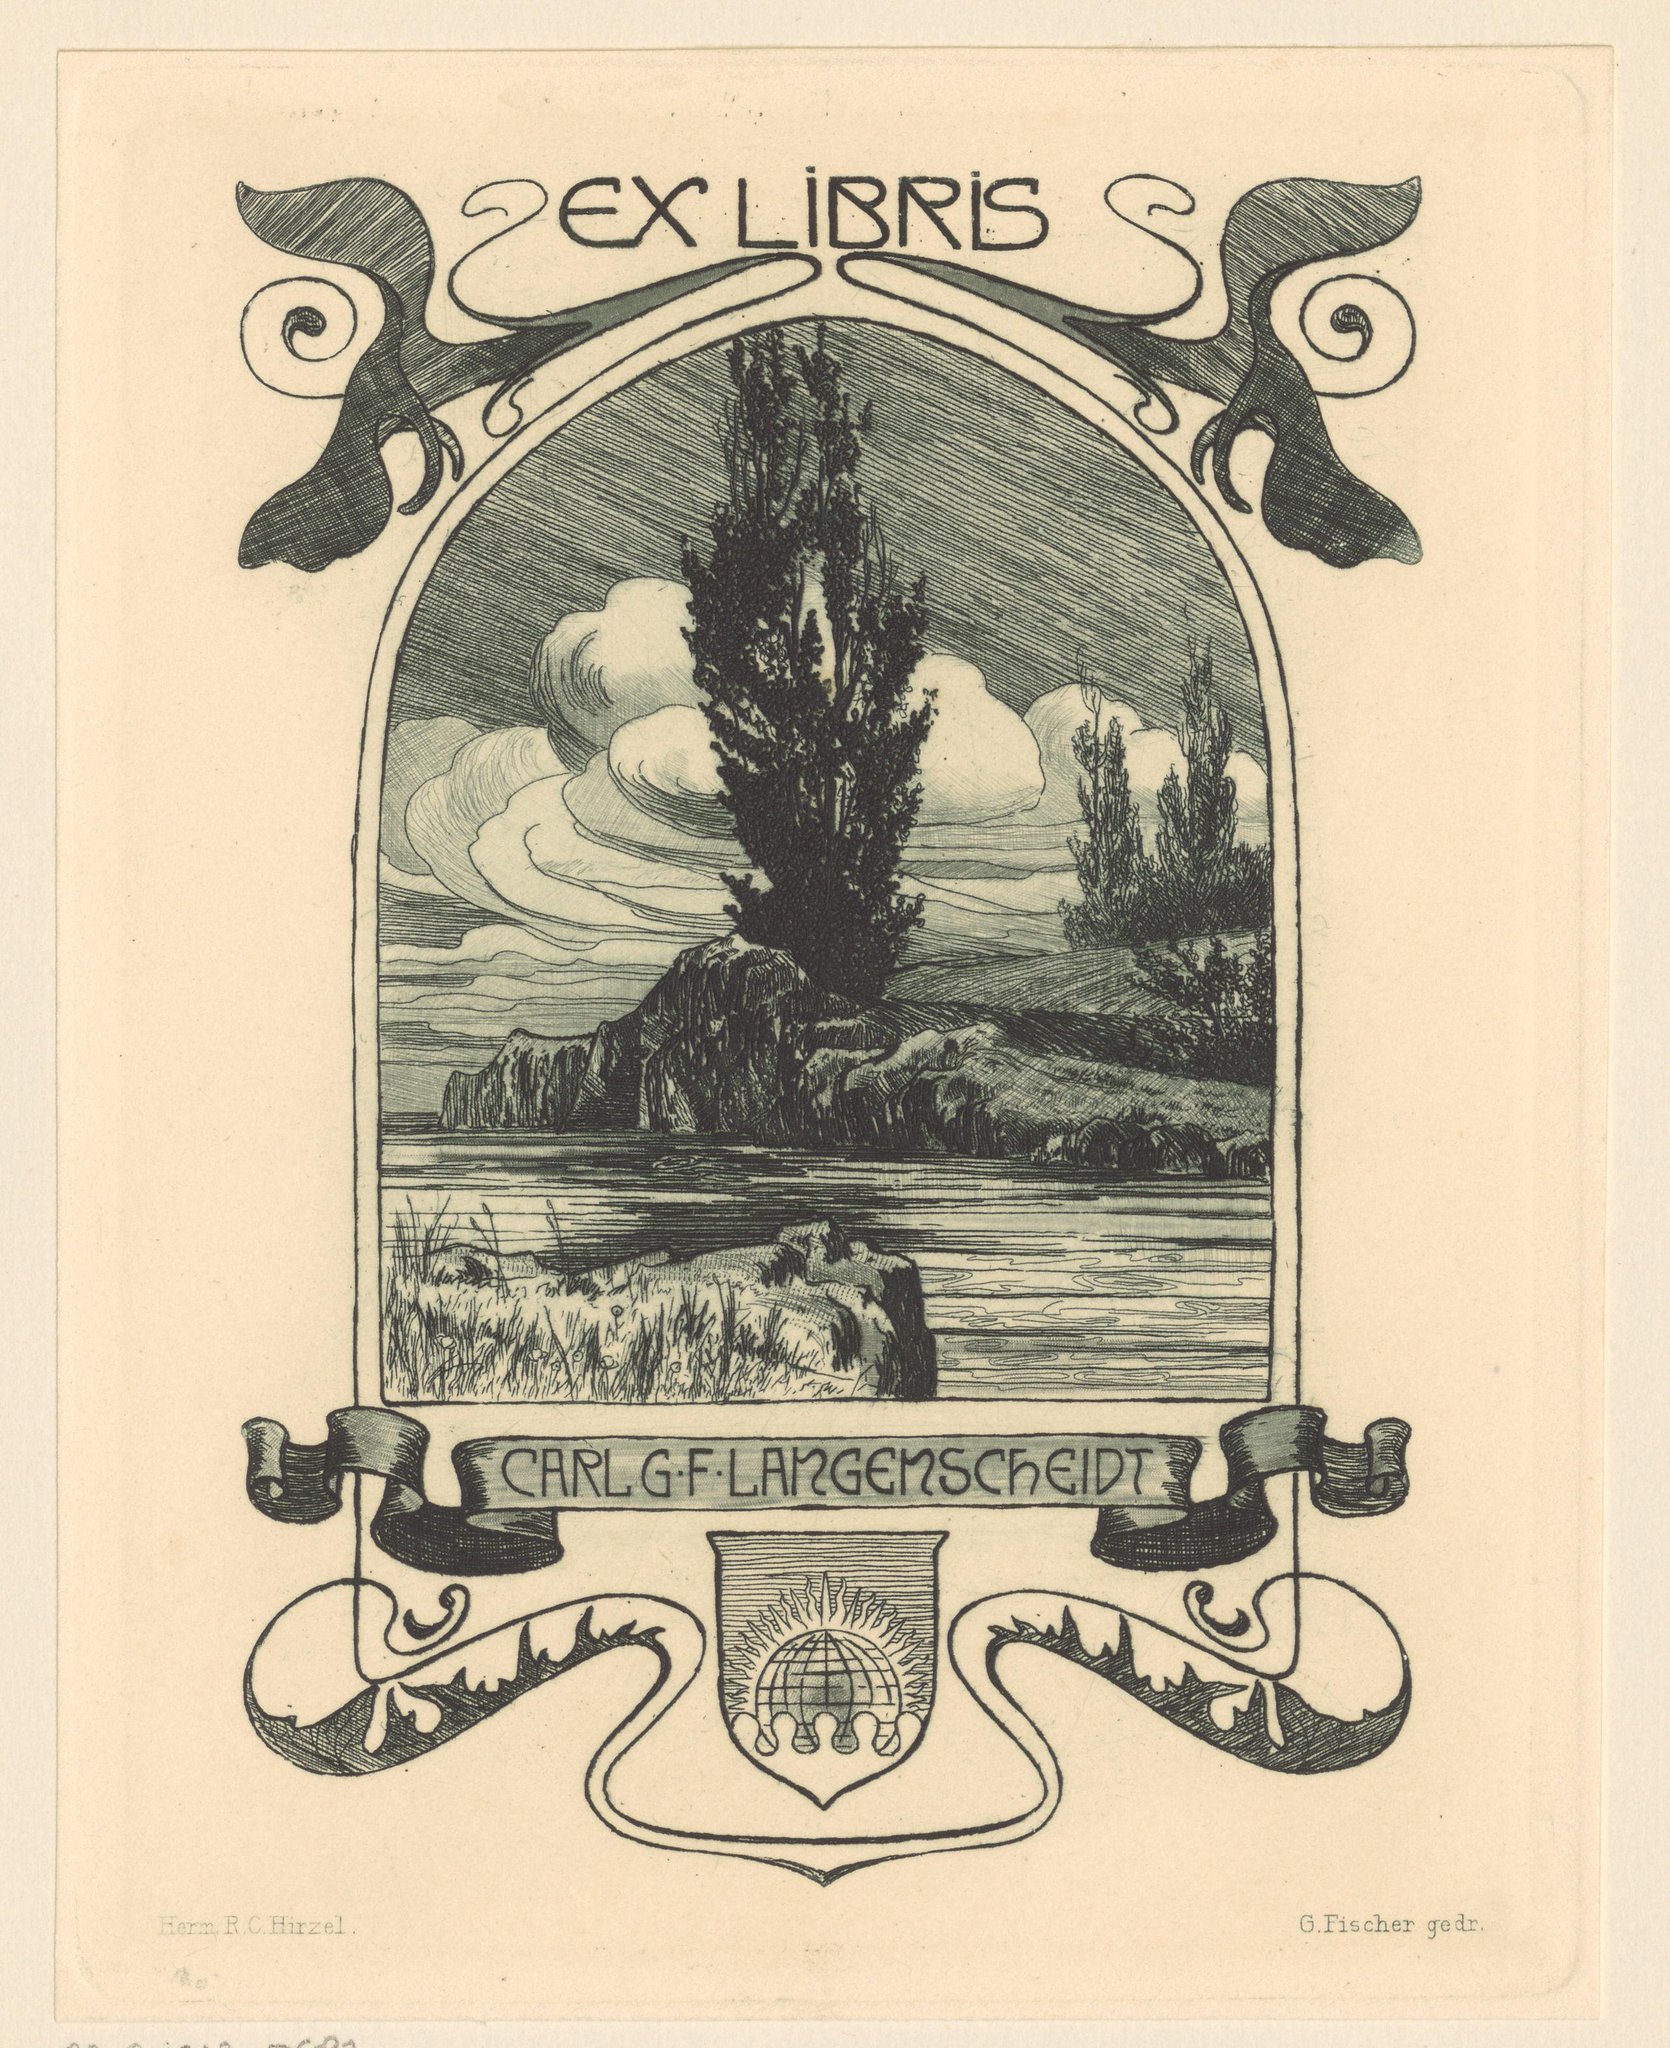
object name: bookplate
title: Ex libris van Carl G.F. Langenscheidt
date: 1880-1913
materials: paper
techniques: etching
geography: switzerland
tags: trees, flowers ~ ornament - aa - stylized, river, globe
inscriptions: collector's mark: Lugt 2760, collector's mark: Lugt 2233